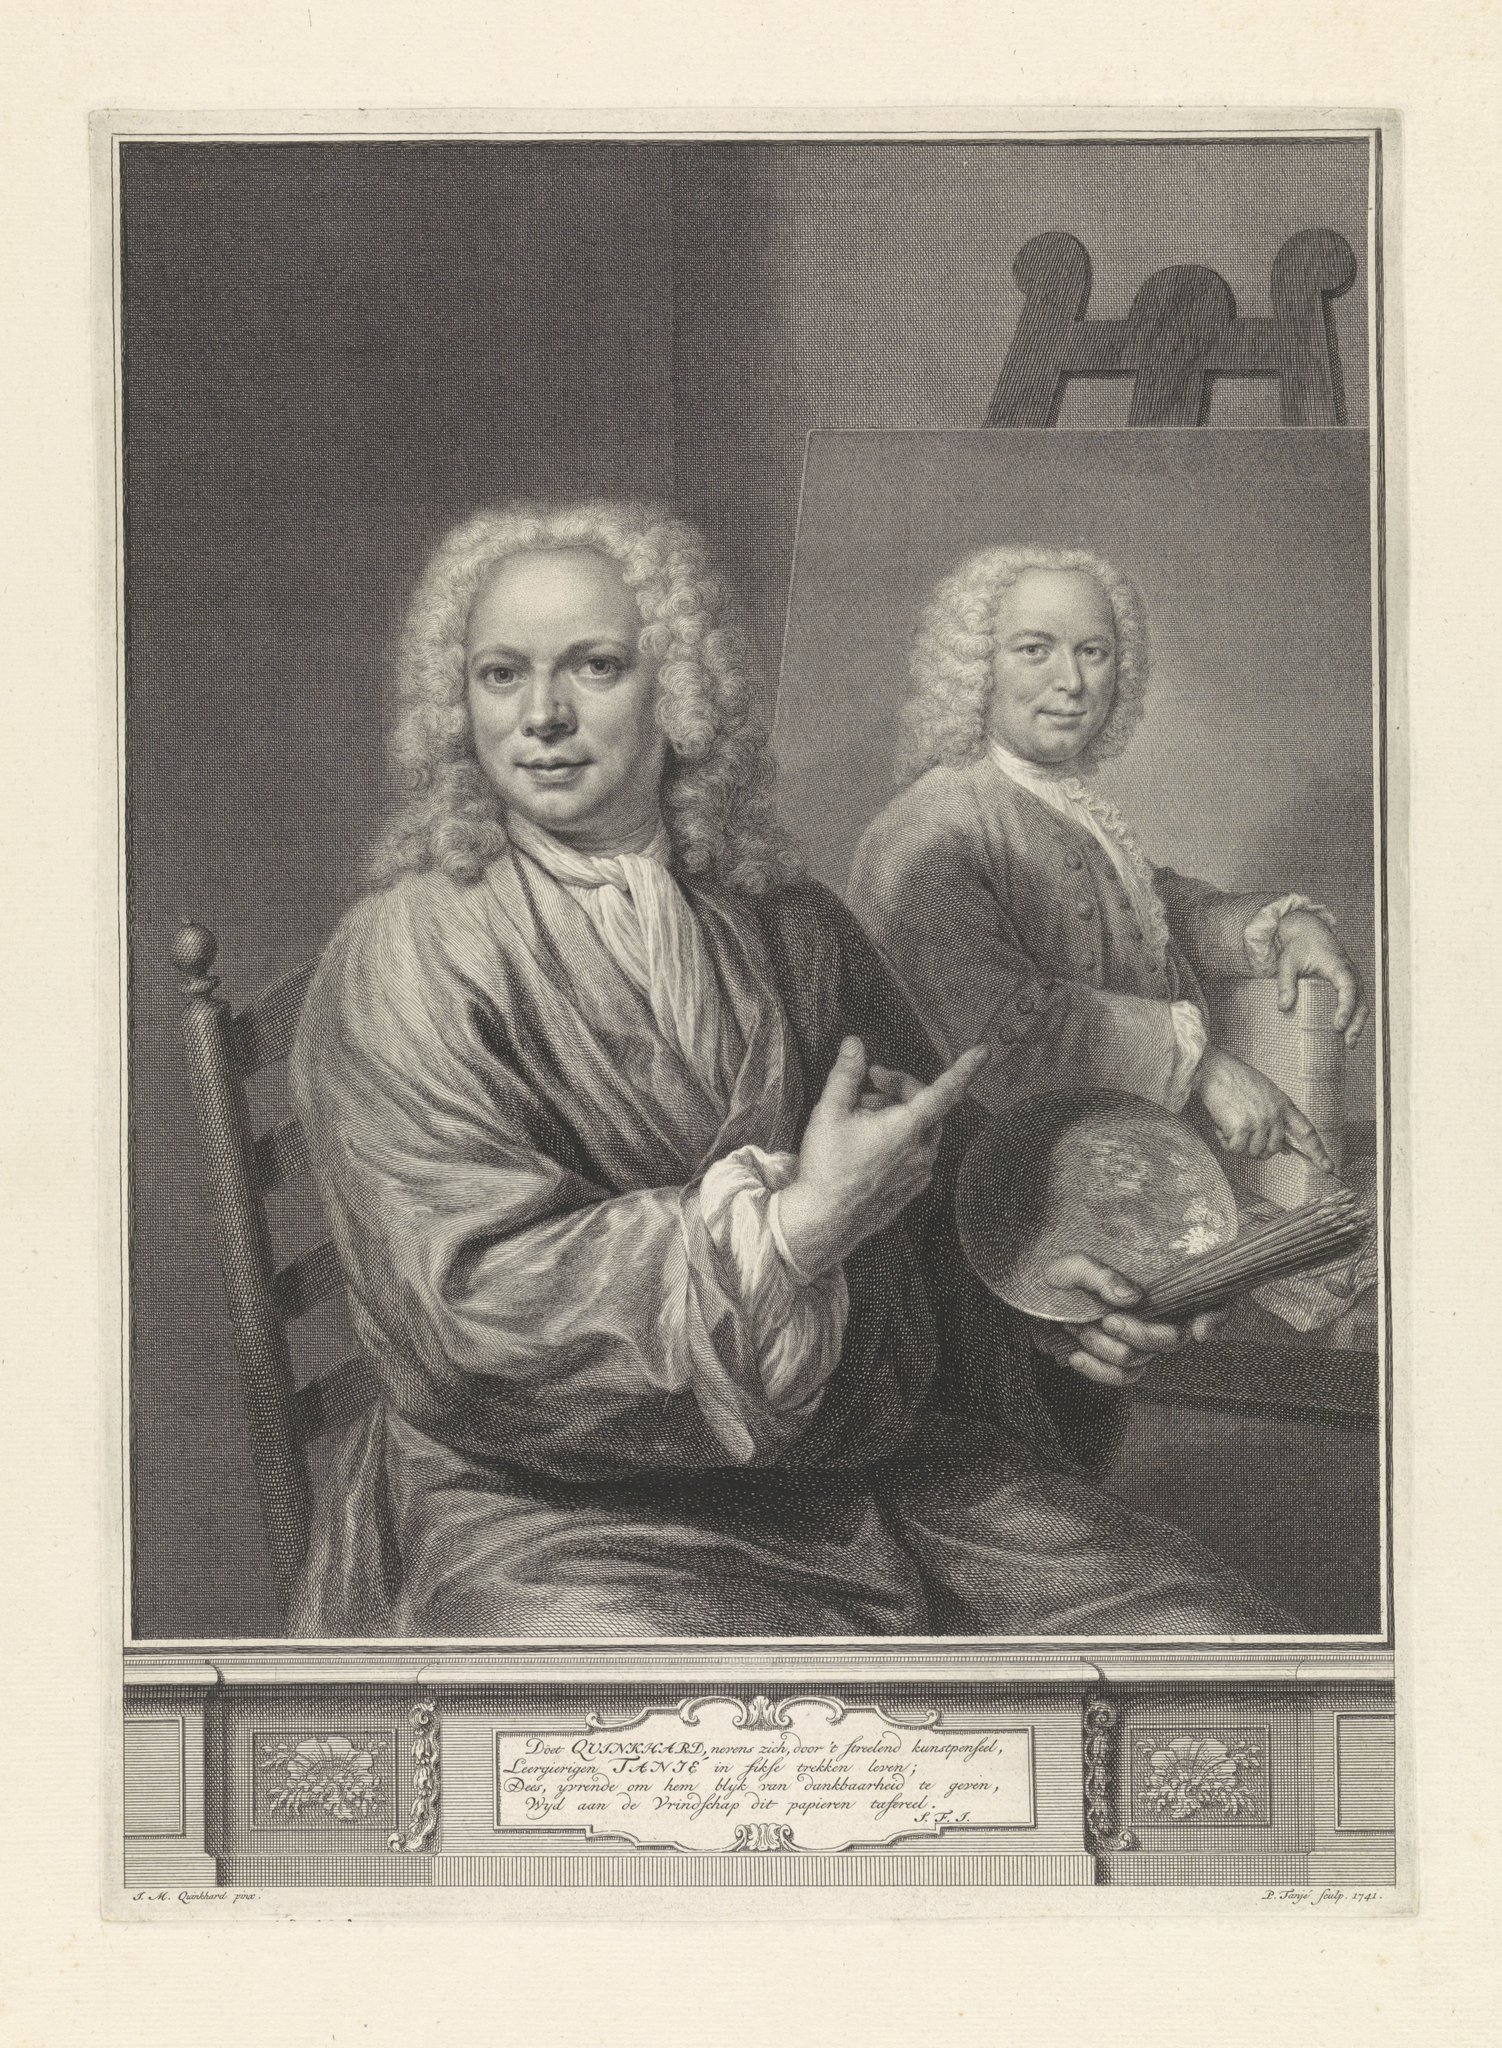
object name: print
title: Portret van Jan Maurits Quinkhard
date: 1741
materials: paper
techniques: engraving, etching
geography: amsterdam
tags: amsterdam, painter, draughtsman, jan maurits quinkhard, print maker, pieter tanjé, portrait, self-portrait of painter, tools, implements of painter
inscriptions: collector's mark: Lugt 240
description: Portret van schilder en tekenaar Jan Maurits Quinkhard, wijzend op het portret van Pieter Tanjé, dat op de schildersezel staat. In zijn hand houdt Quinckhard een palet en bundel penselen. Onder het portret een vierregelig vers in het Nederlands.